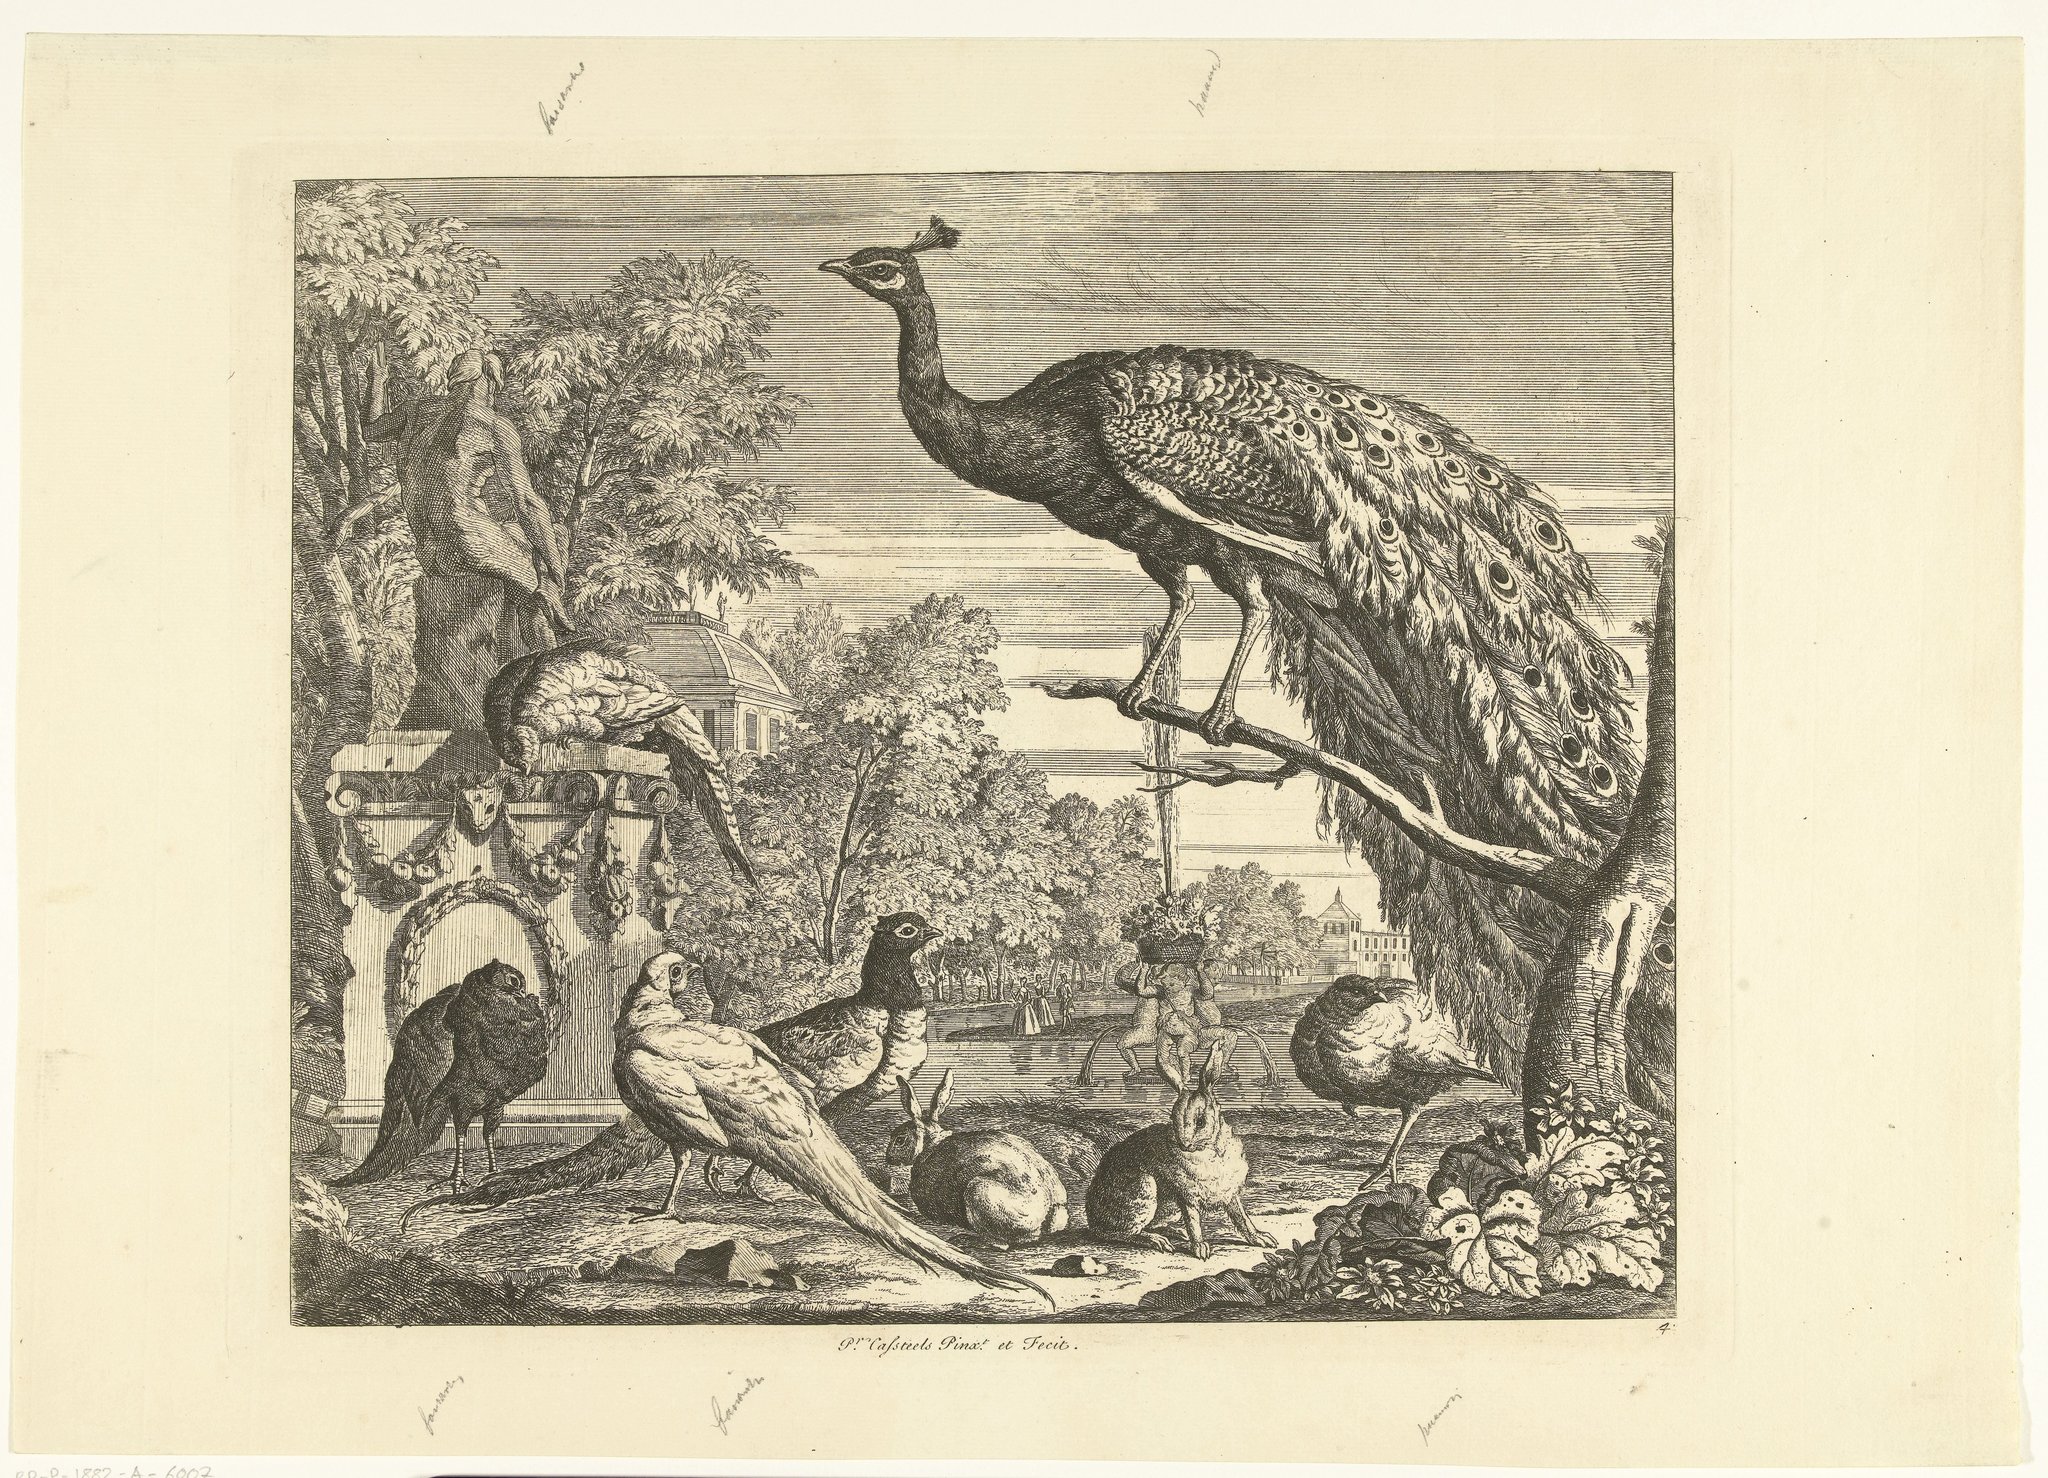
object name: print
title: Pauw, konijnen en andere vogels bij een tuinfontein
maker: peter casteels (iii)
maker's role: draughtsman, print maker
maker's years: 1684-1749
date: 1708-1749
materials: paper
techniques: etching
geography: london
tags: garden fountain, ornamental birds: peacock, statues, sculptures in garden, rodents: rabbit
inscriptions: collector's mark: Lugt 2228